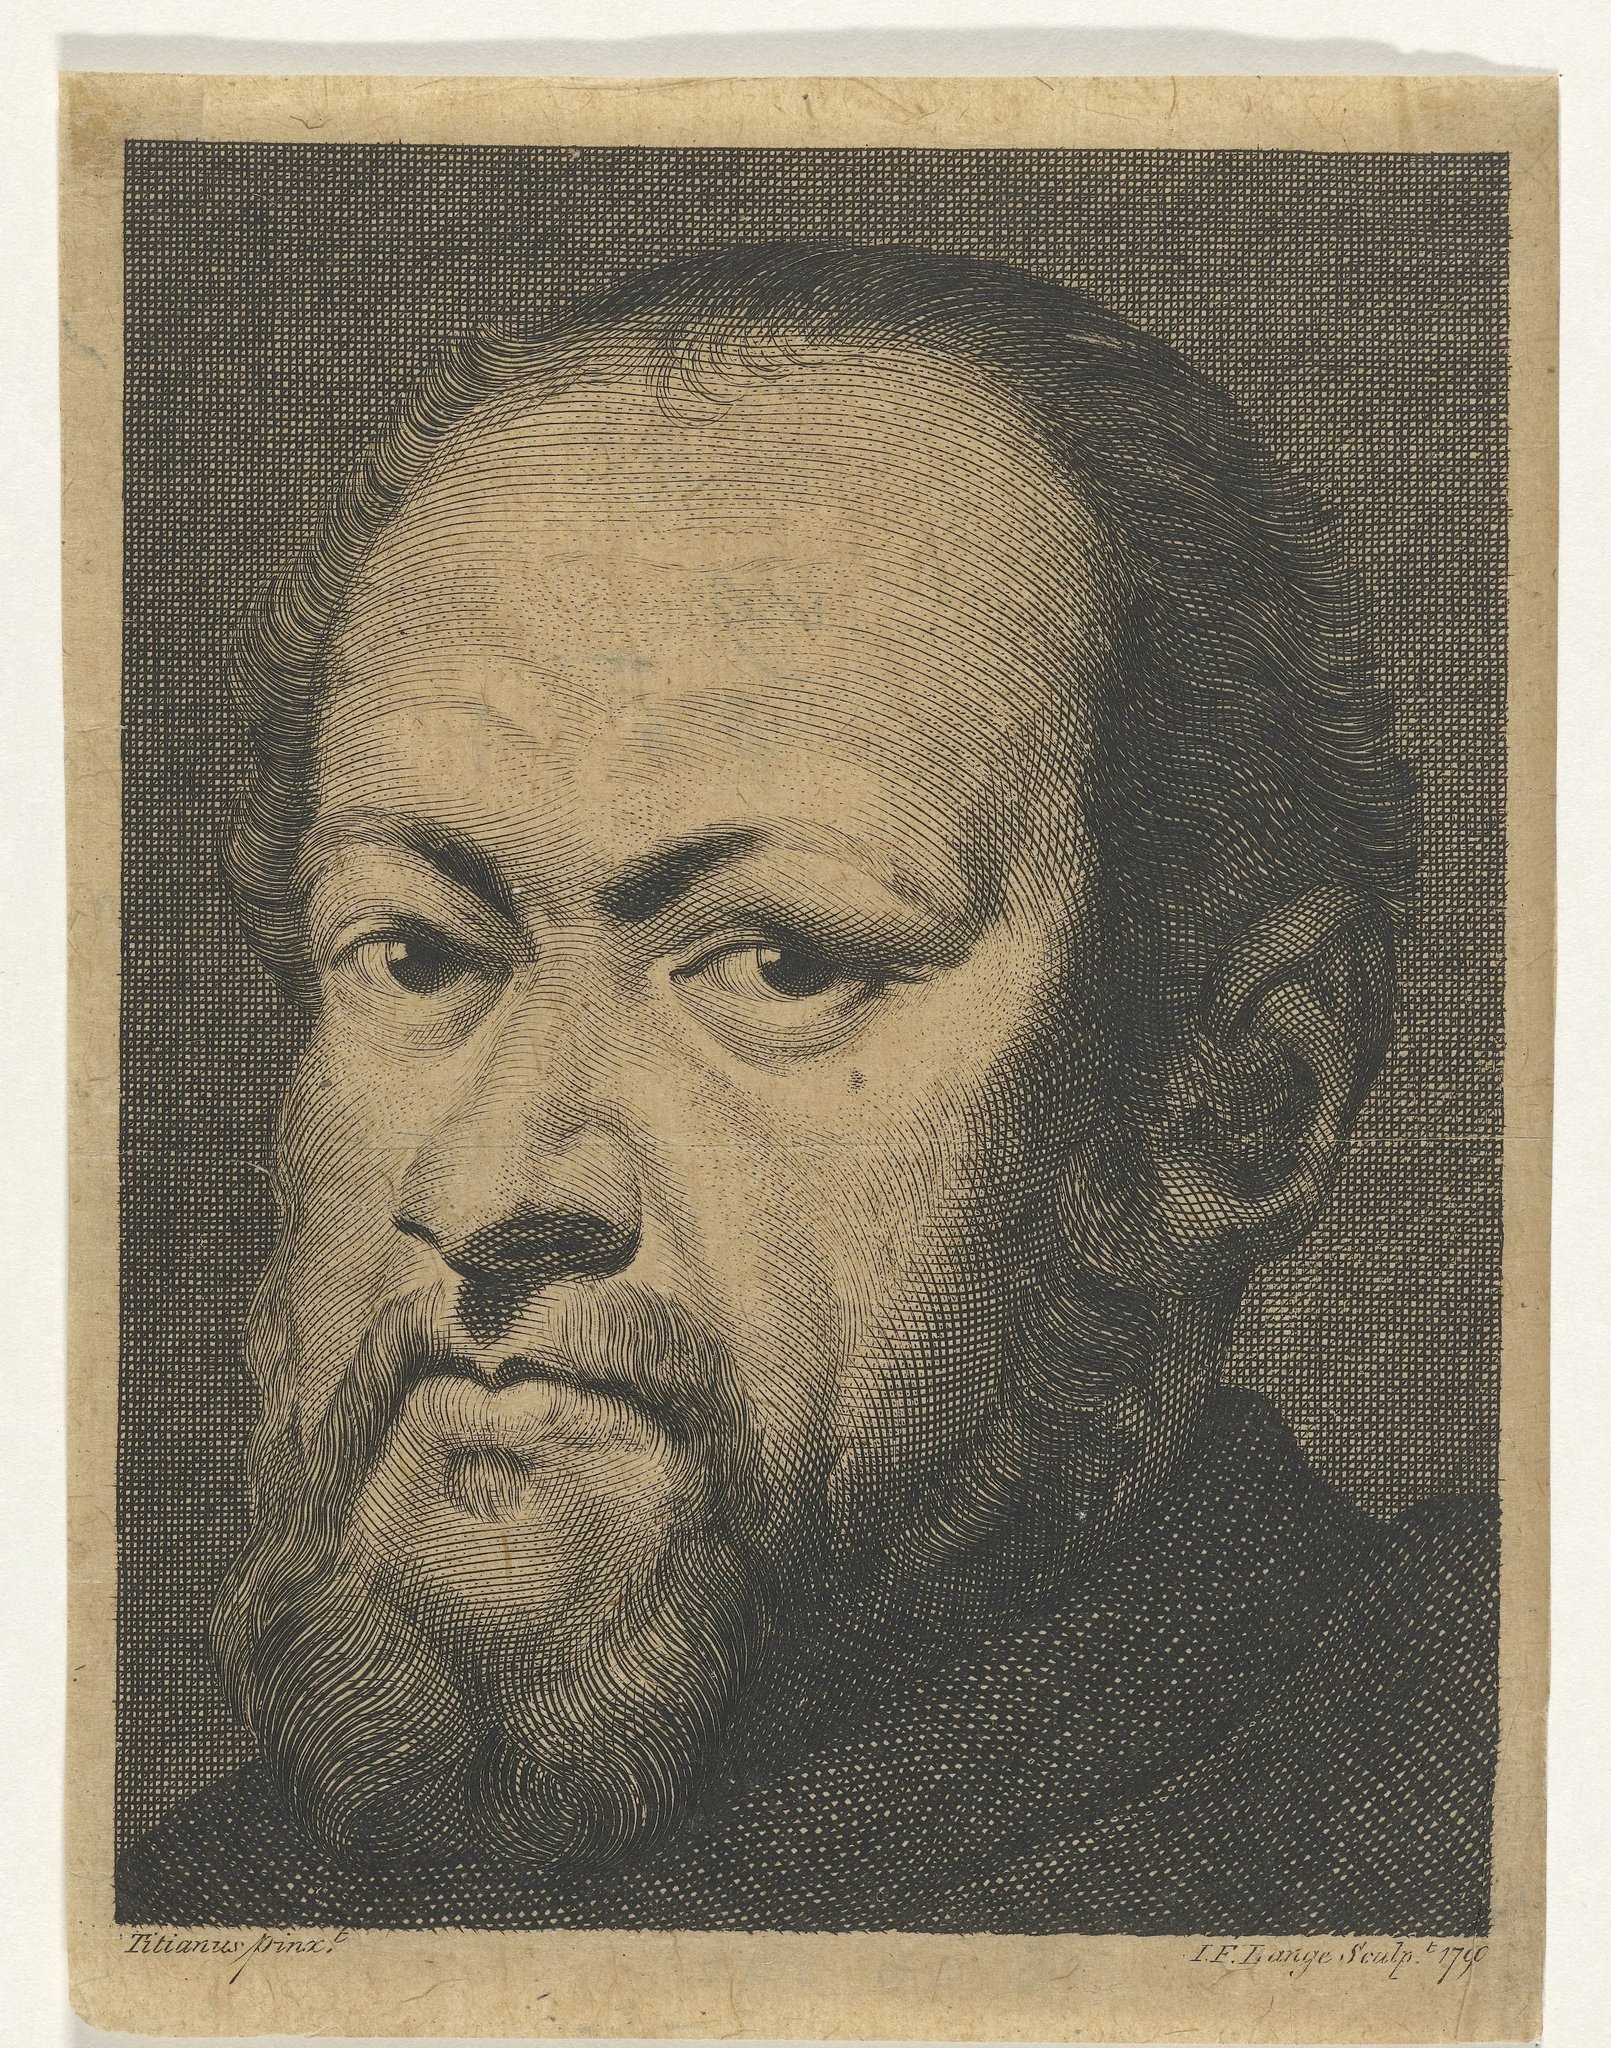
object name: print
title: Portret van een onbekende man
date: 1790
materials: paper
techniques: engraving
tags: anonymous historical person portrayed alone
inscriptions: collector's mark: Lugt 2228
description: Kop van een onbekende man met baard, blootshoofd en driekwart naar links gedraaid.